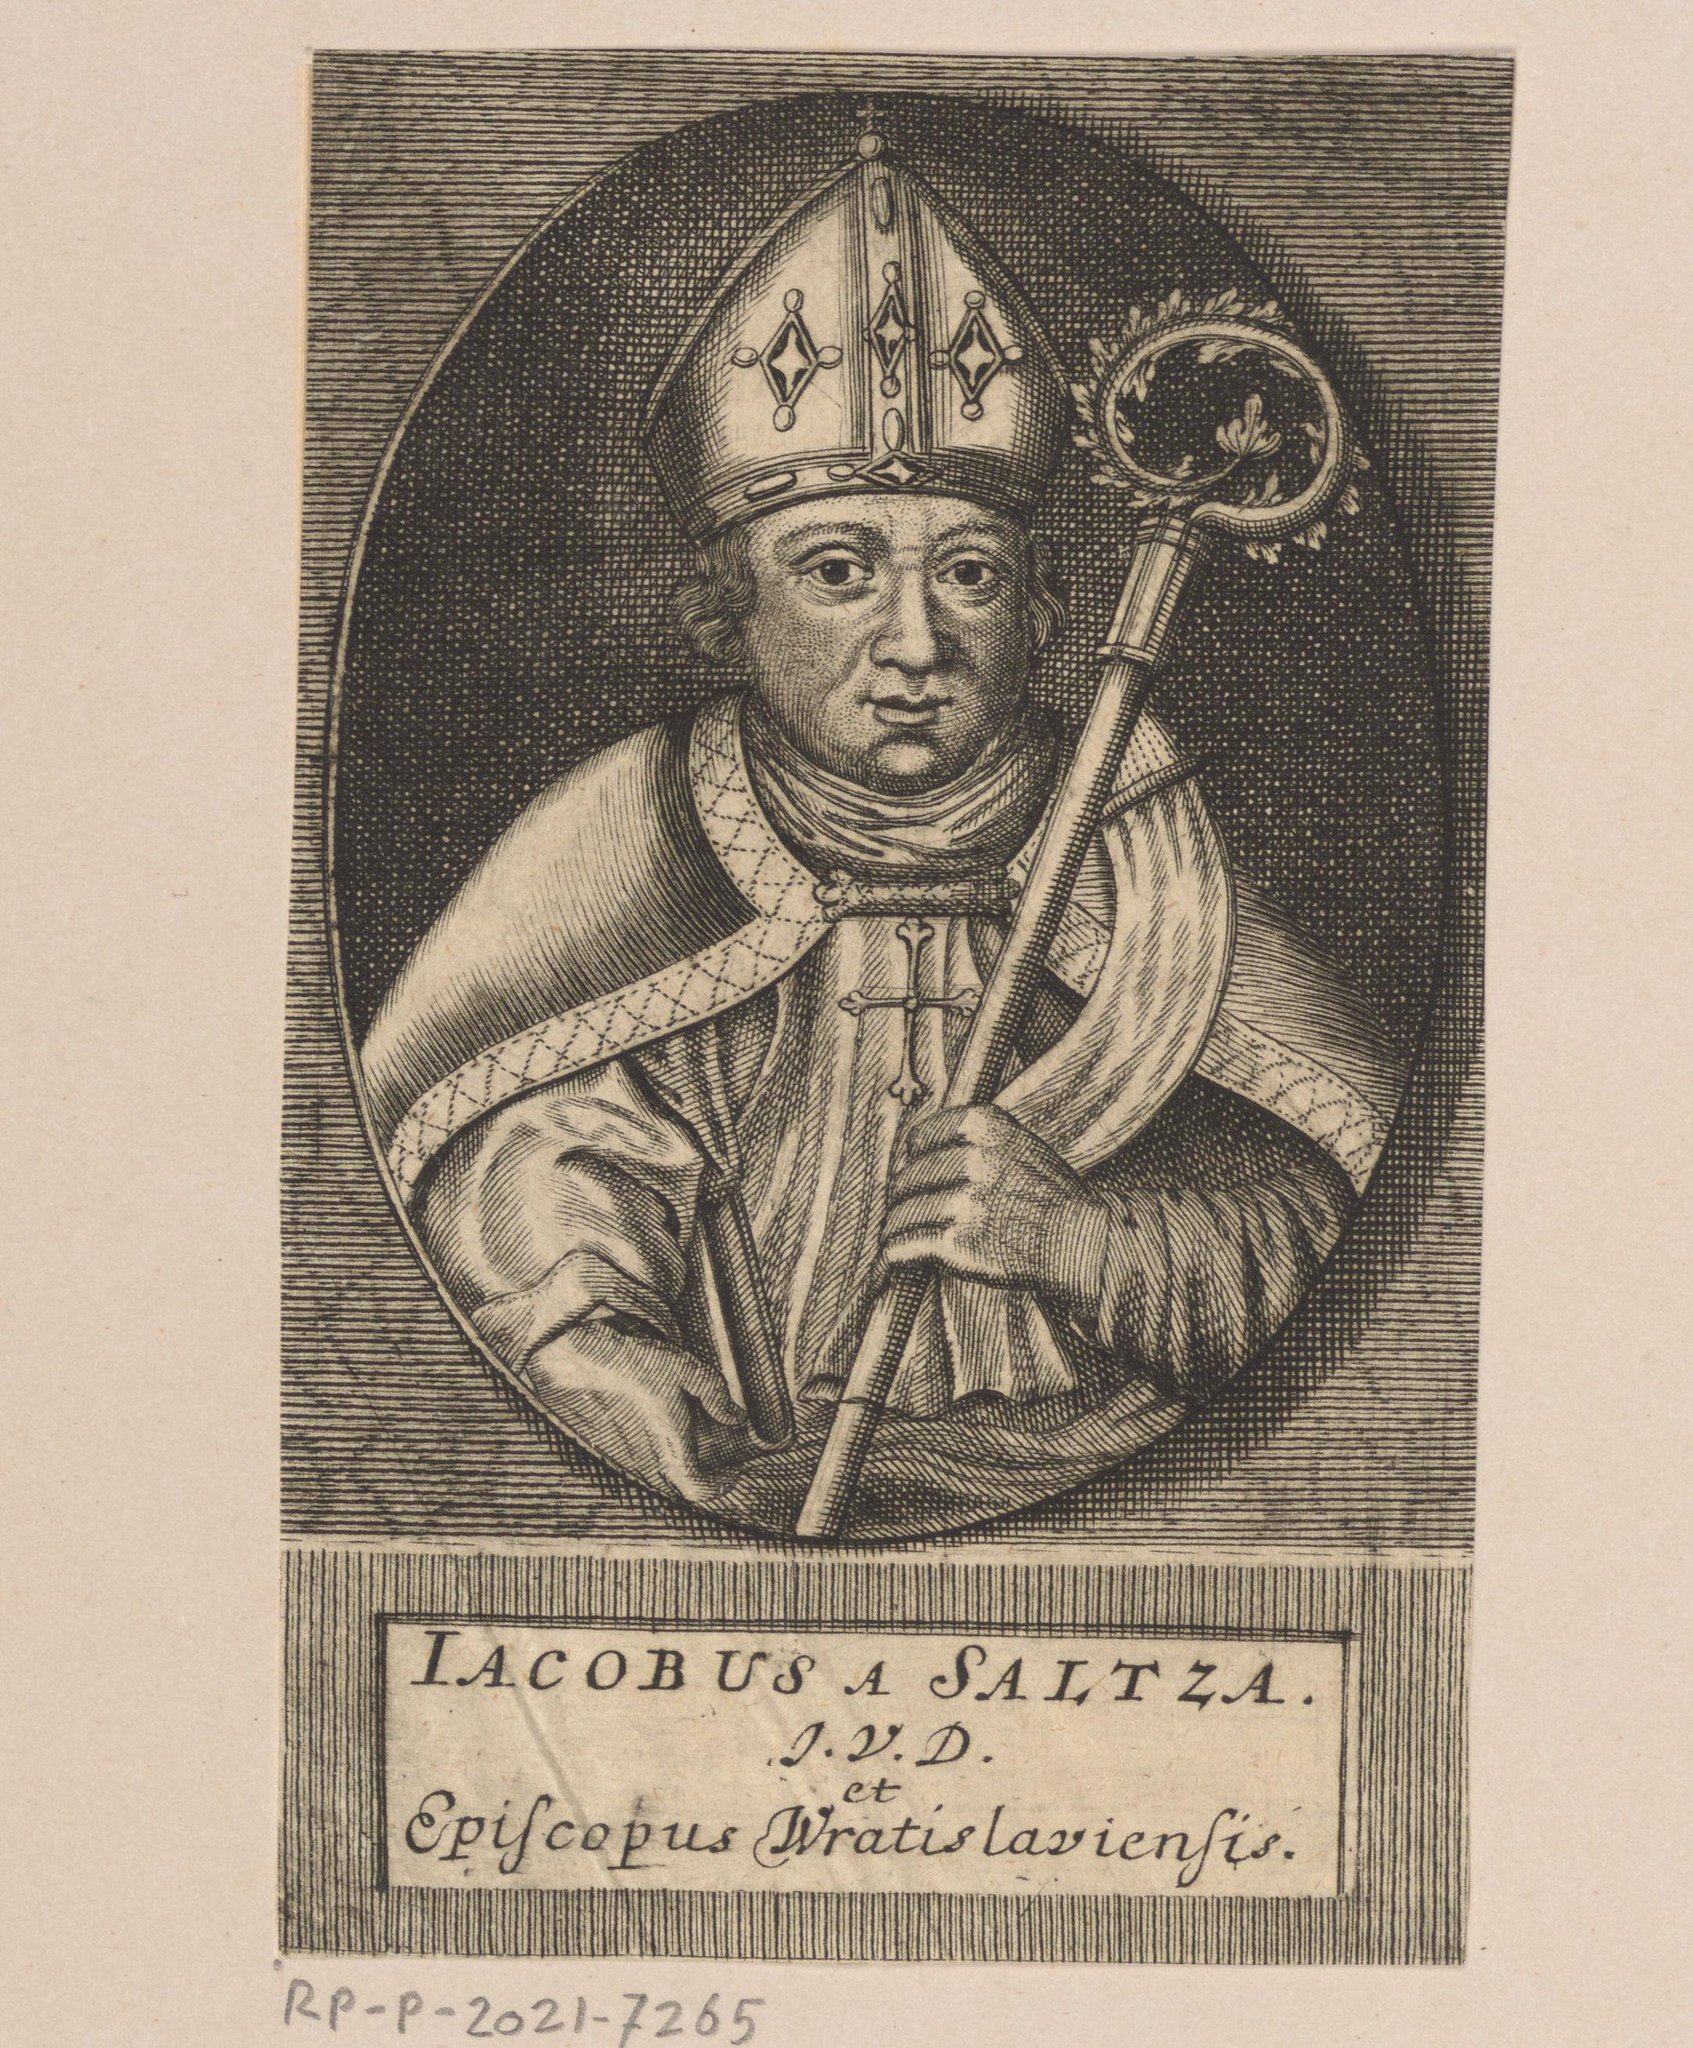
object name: print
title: Portret van Jakob von Salza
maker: Anonymous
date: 1650-1749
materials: paper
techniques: engraving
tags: archbishop, bishop, etc. (roman catholic), historical persons